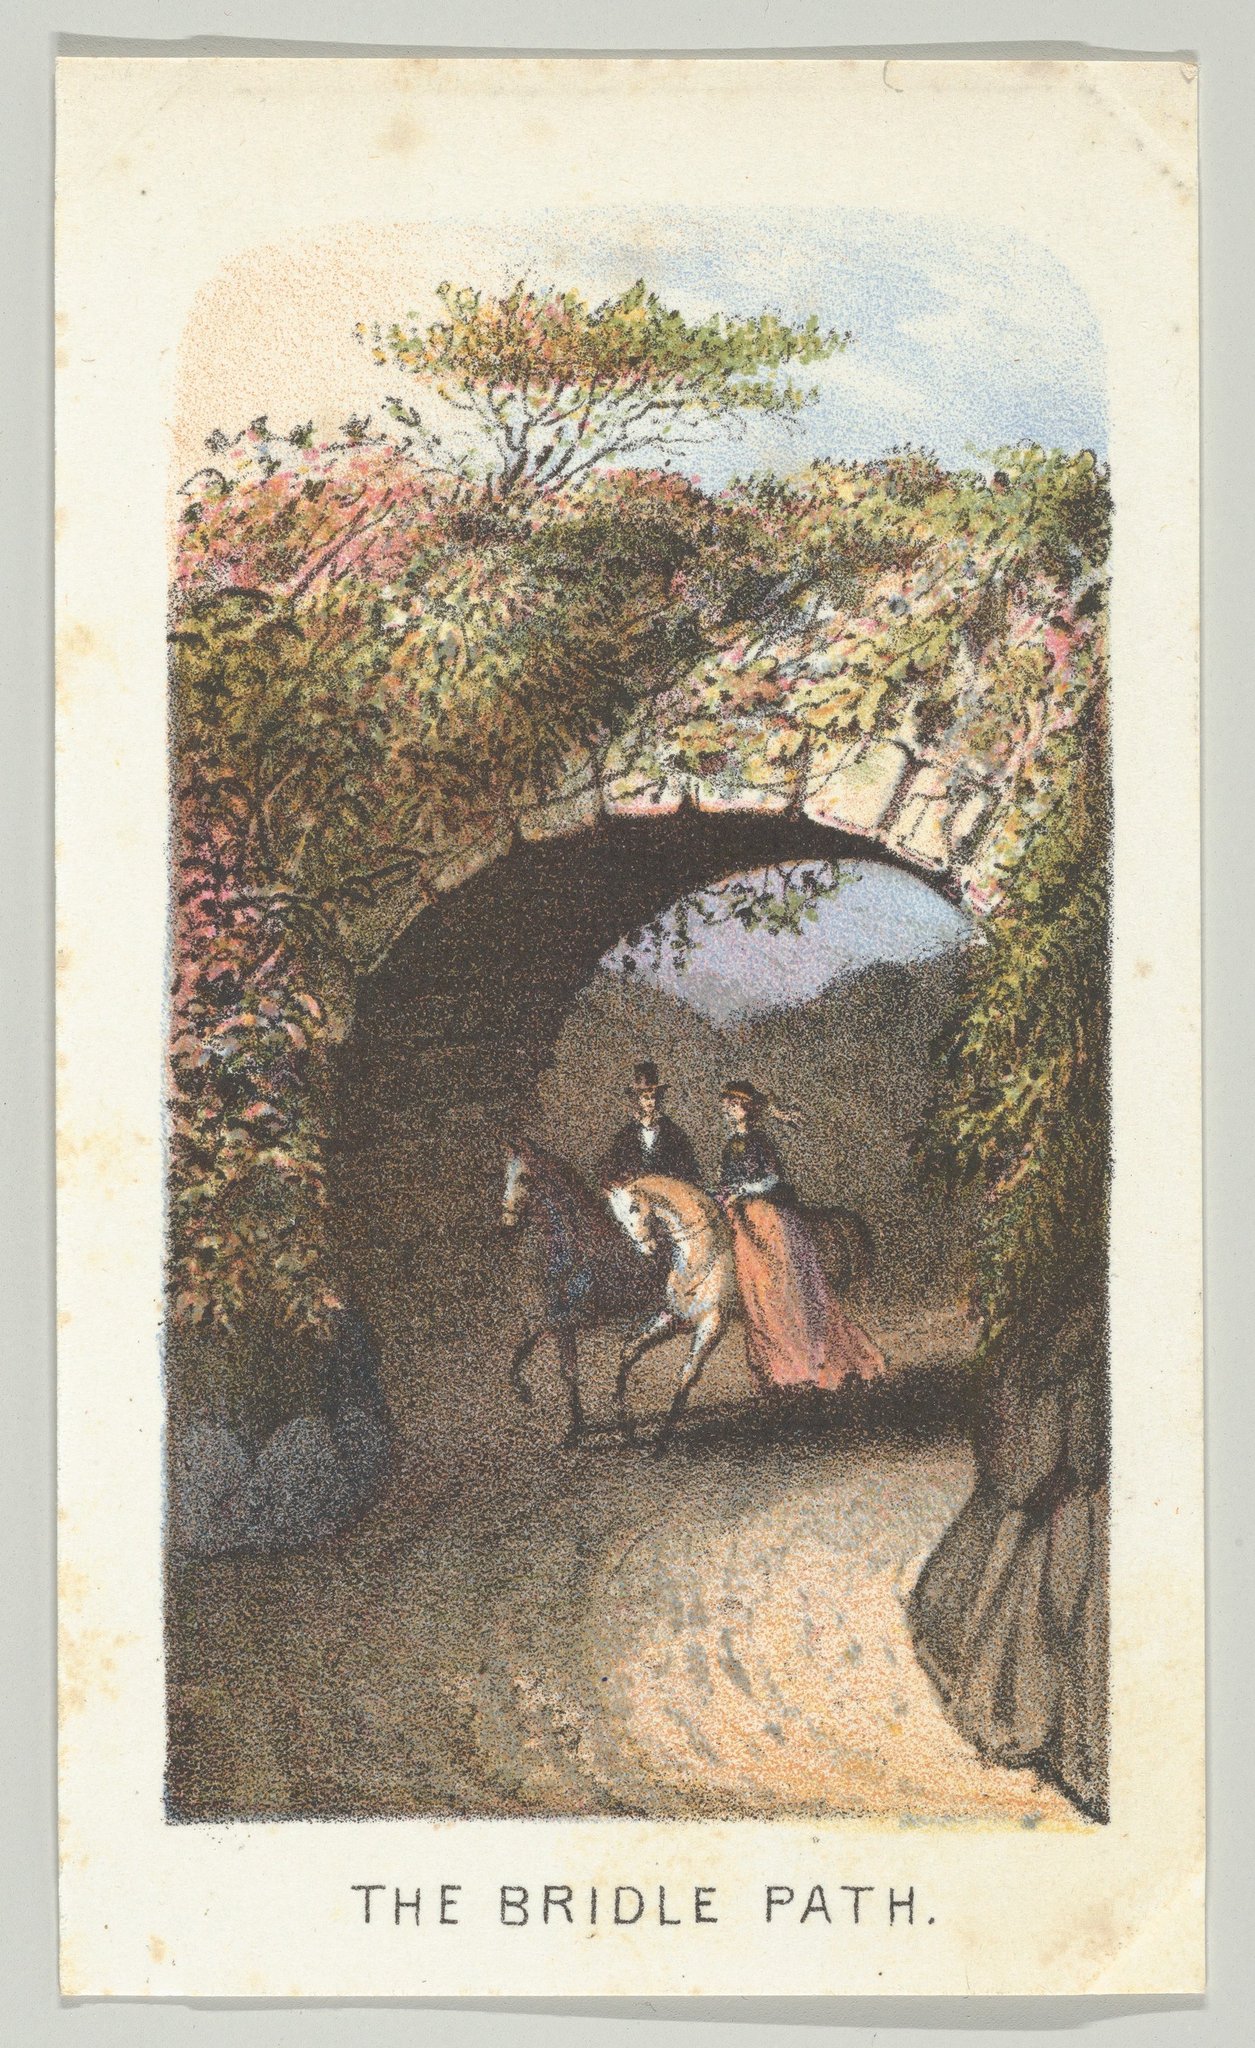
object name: print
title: The Bridle Path, from the series, Views in Central Park, New York, Part 2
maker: louis prang & co.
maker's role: publisher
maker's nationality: american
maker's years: 1800-1950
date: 1864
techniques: lithograph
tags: roads,men,women,horses